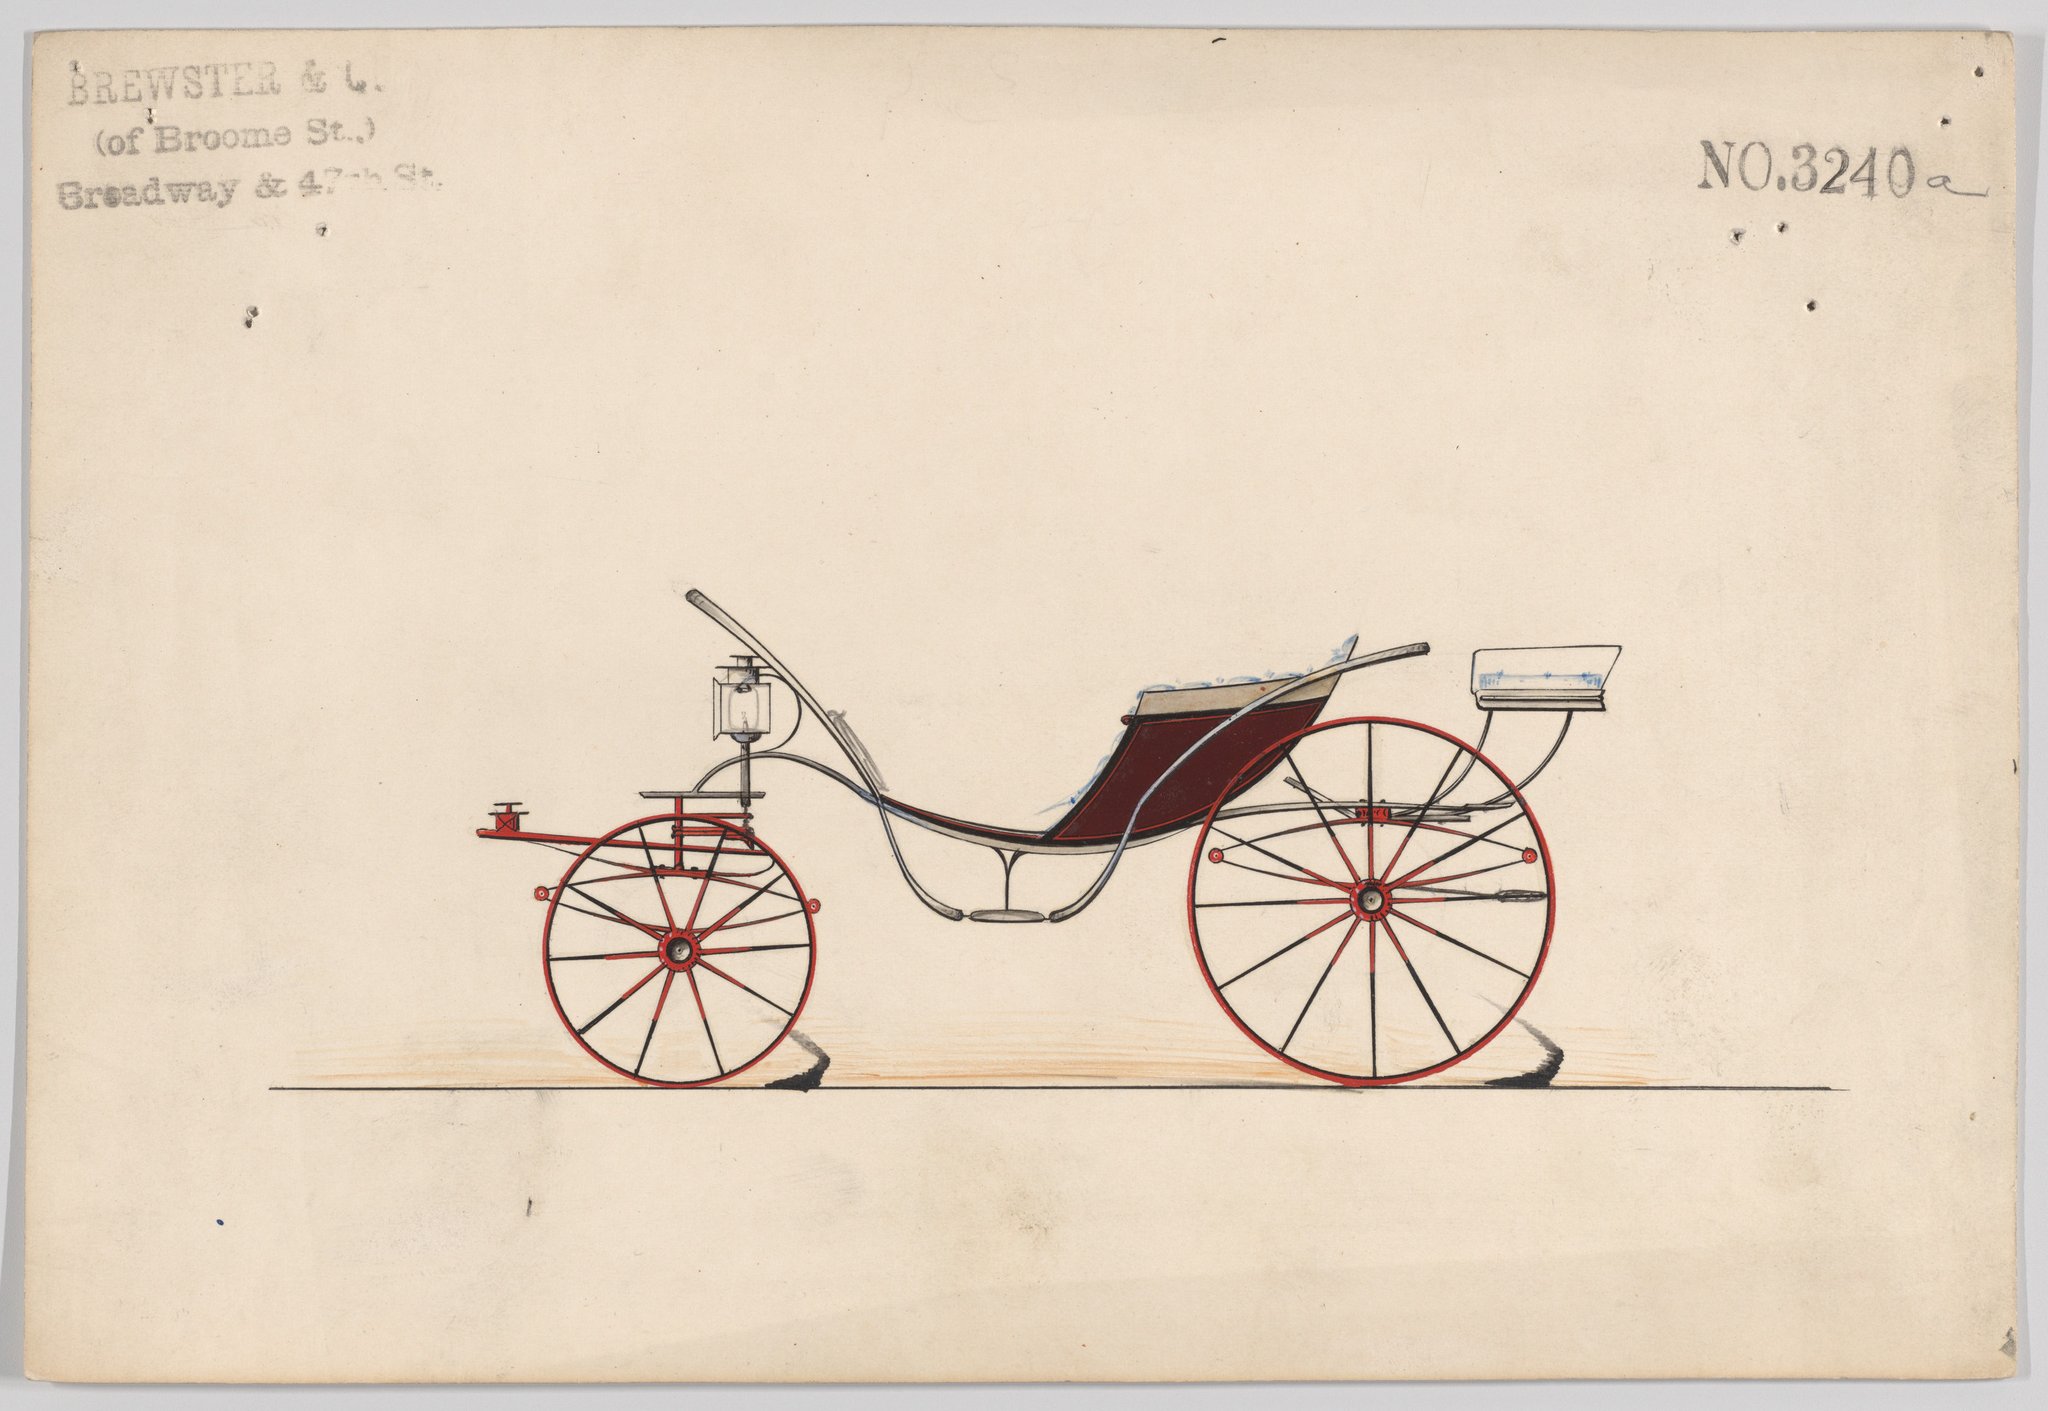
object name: drawing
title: Design for Pony Phaeton, no. 3240a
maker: brewster & co.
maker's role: manufacturer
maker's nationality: american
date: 1876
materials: gouache, gum arabic, ink, watercolor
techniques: pen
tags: carriages